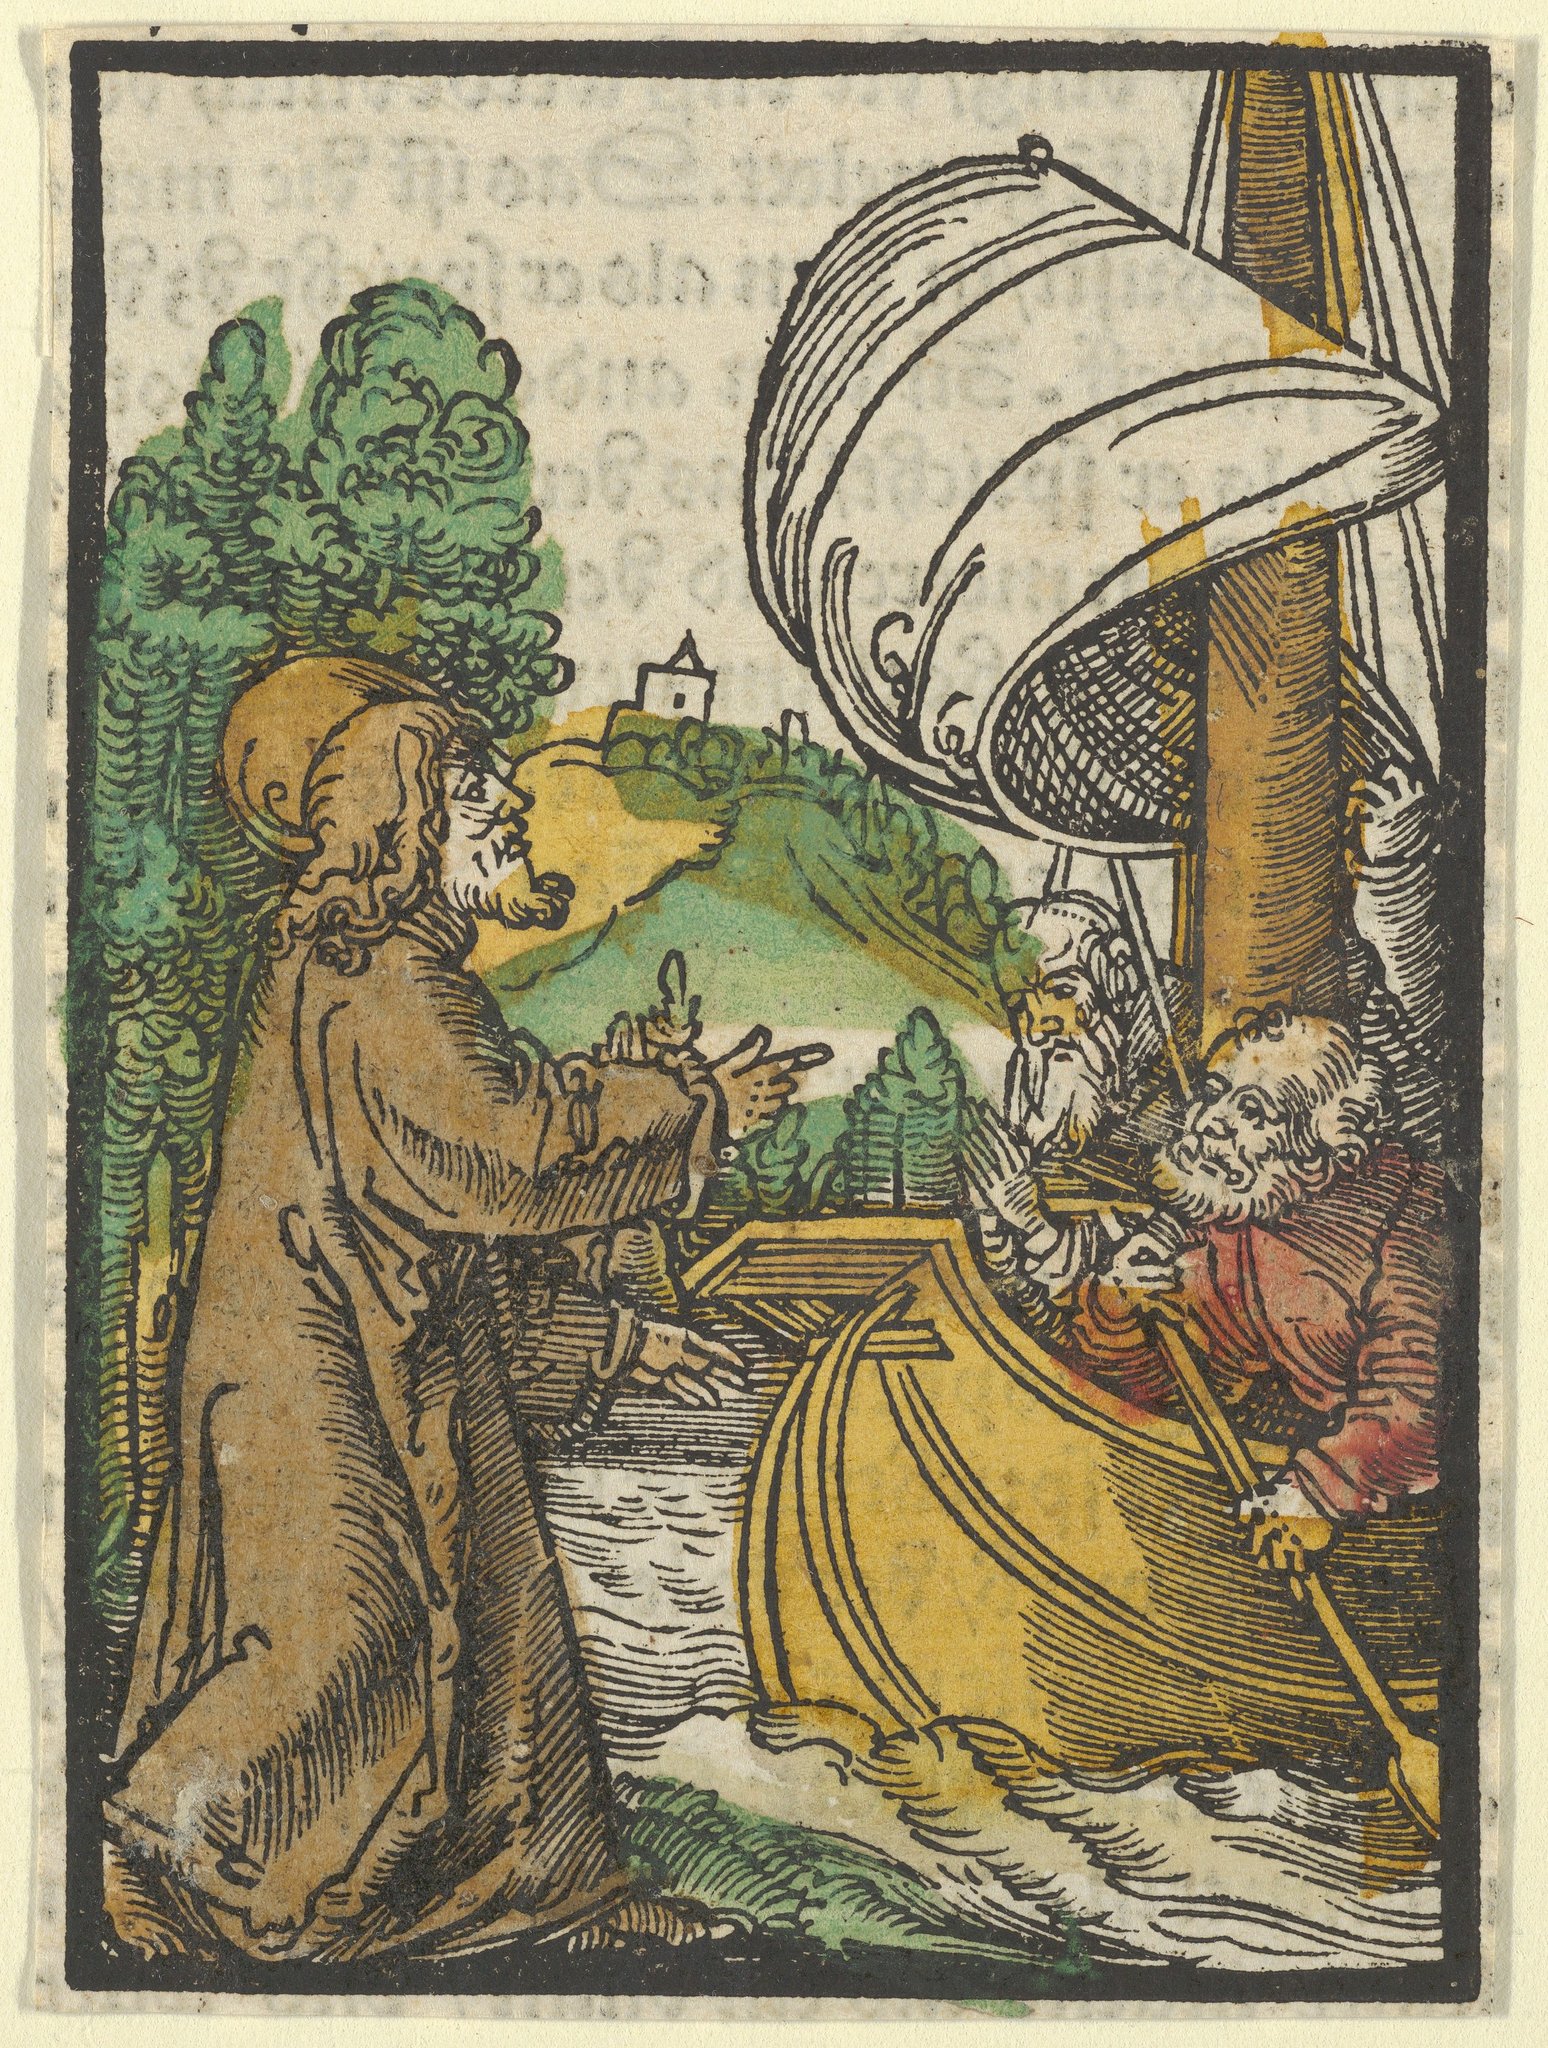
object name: print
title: Christ Calming the Storm on Lake Tiberias, from Das Plenarium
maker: hans schäufelein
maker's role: artist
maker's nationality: german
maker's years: 1480-1540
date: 1517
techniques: hand coloring, woodcut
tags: men,lakes,christ,praying,boats